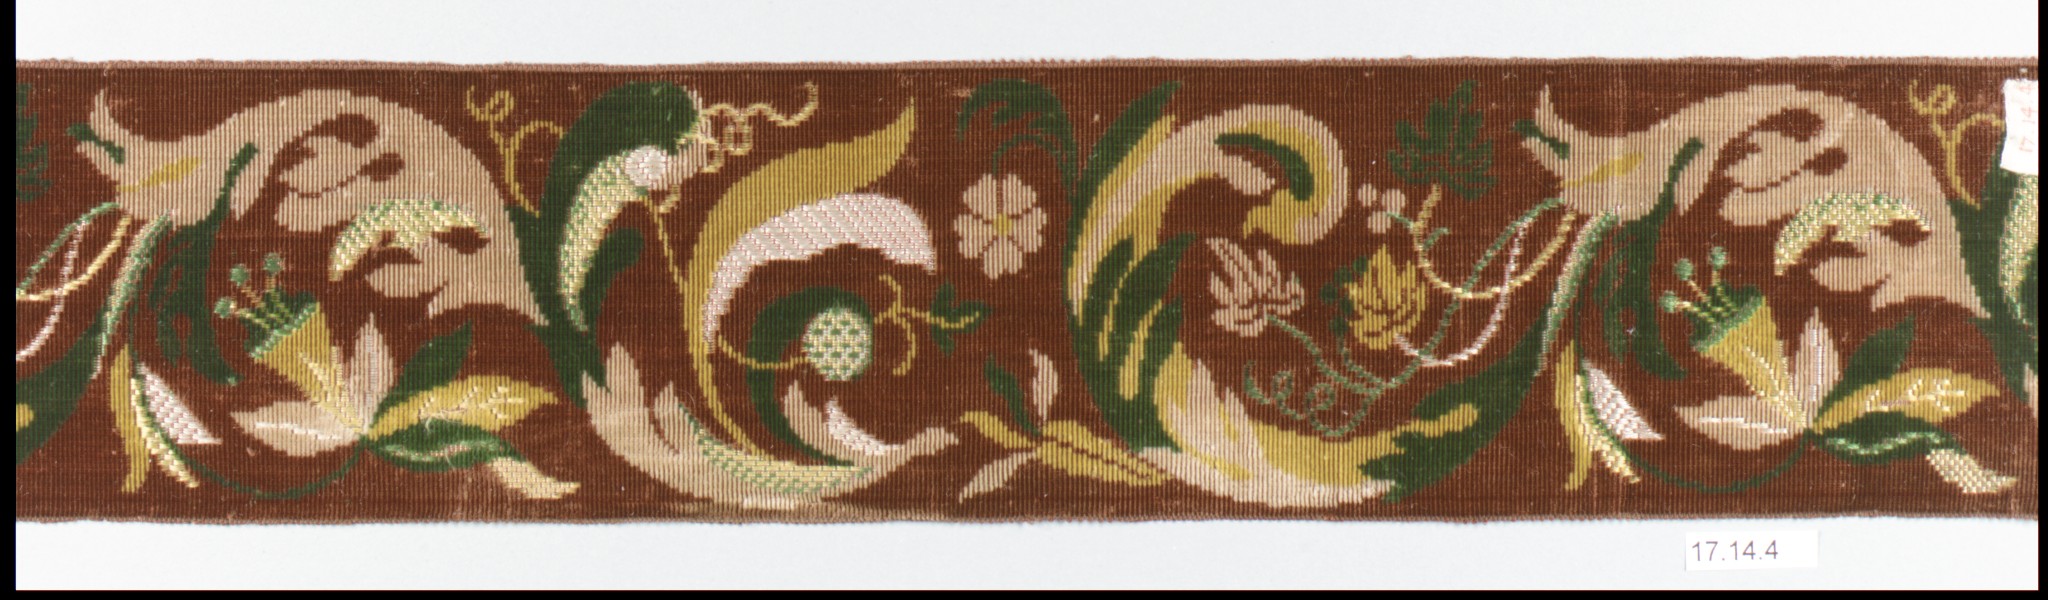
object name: ribbon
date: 1701-1800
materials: velvet